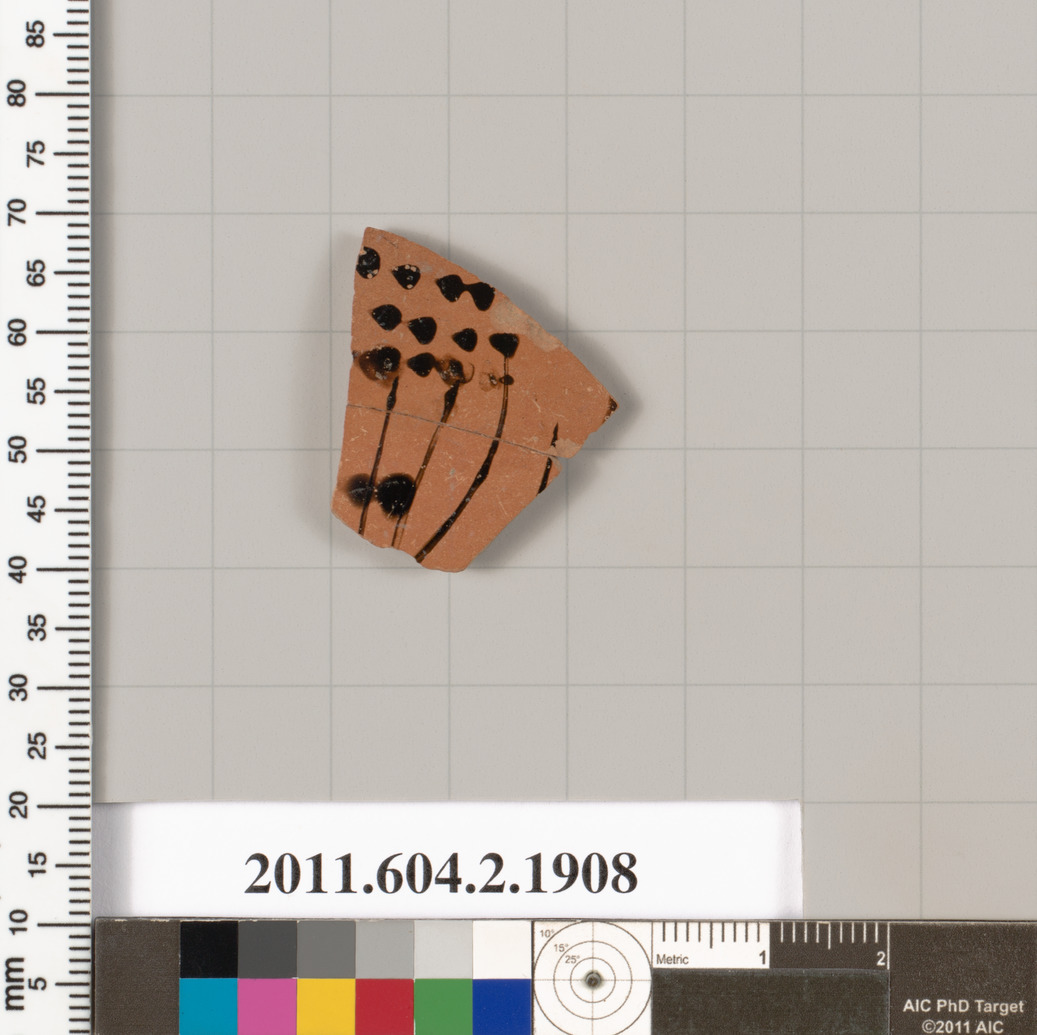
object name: skyphos fragment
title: Terracotta fragment of a skyphos (deep drinking cup)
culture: greek, attic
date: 460-430 BCE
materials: terracotta